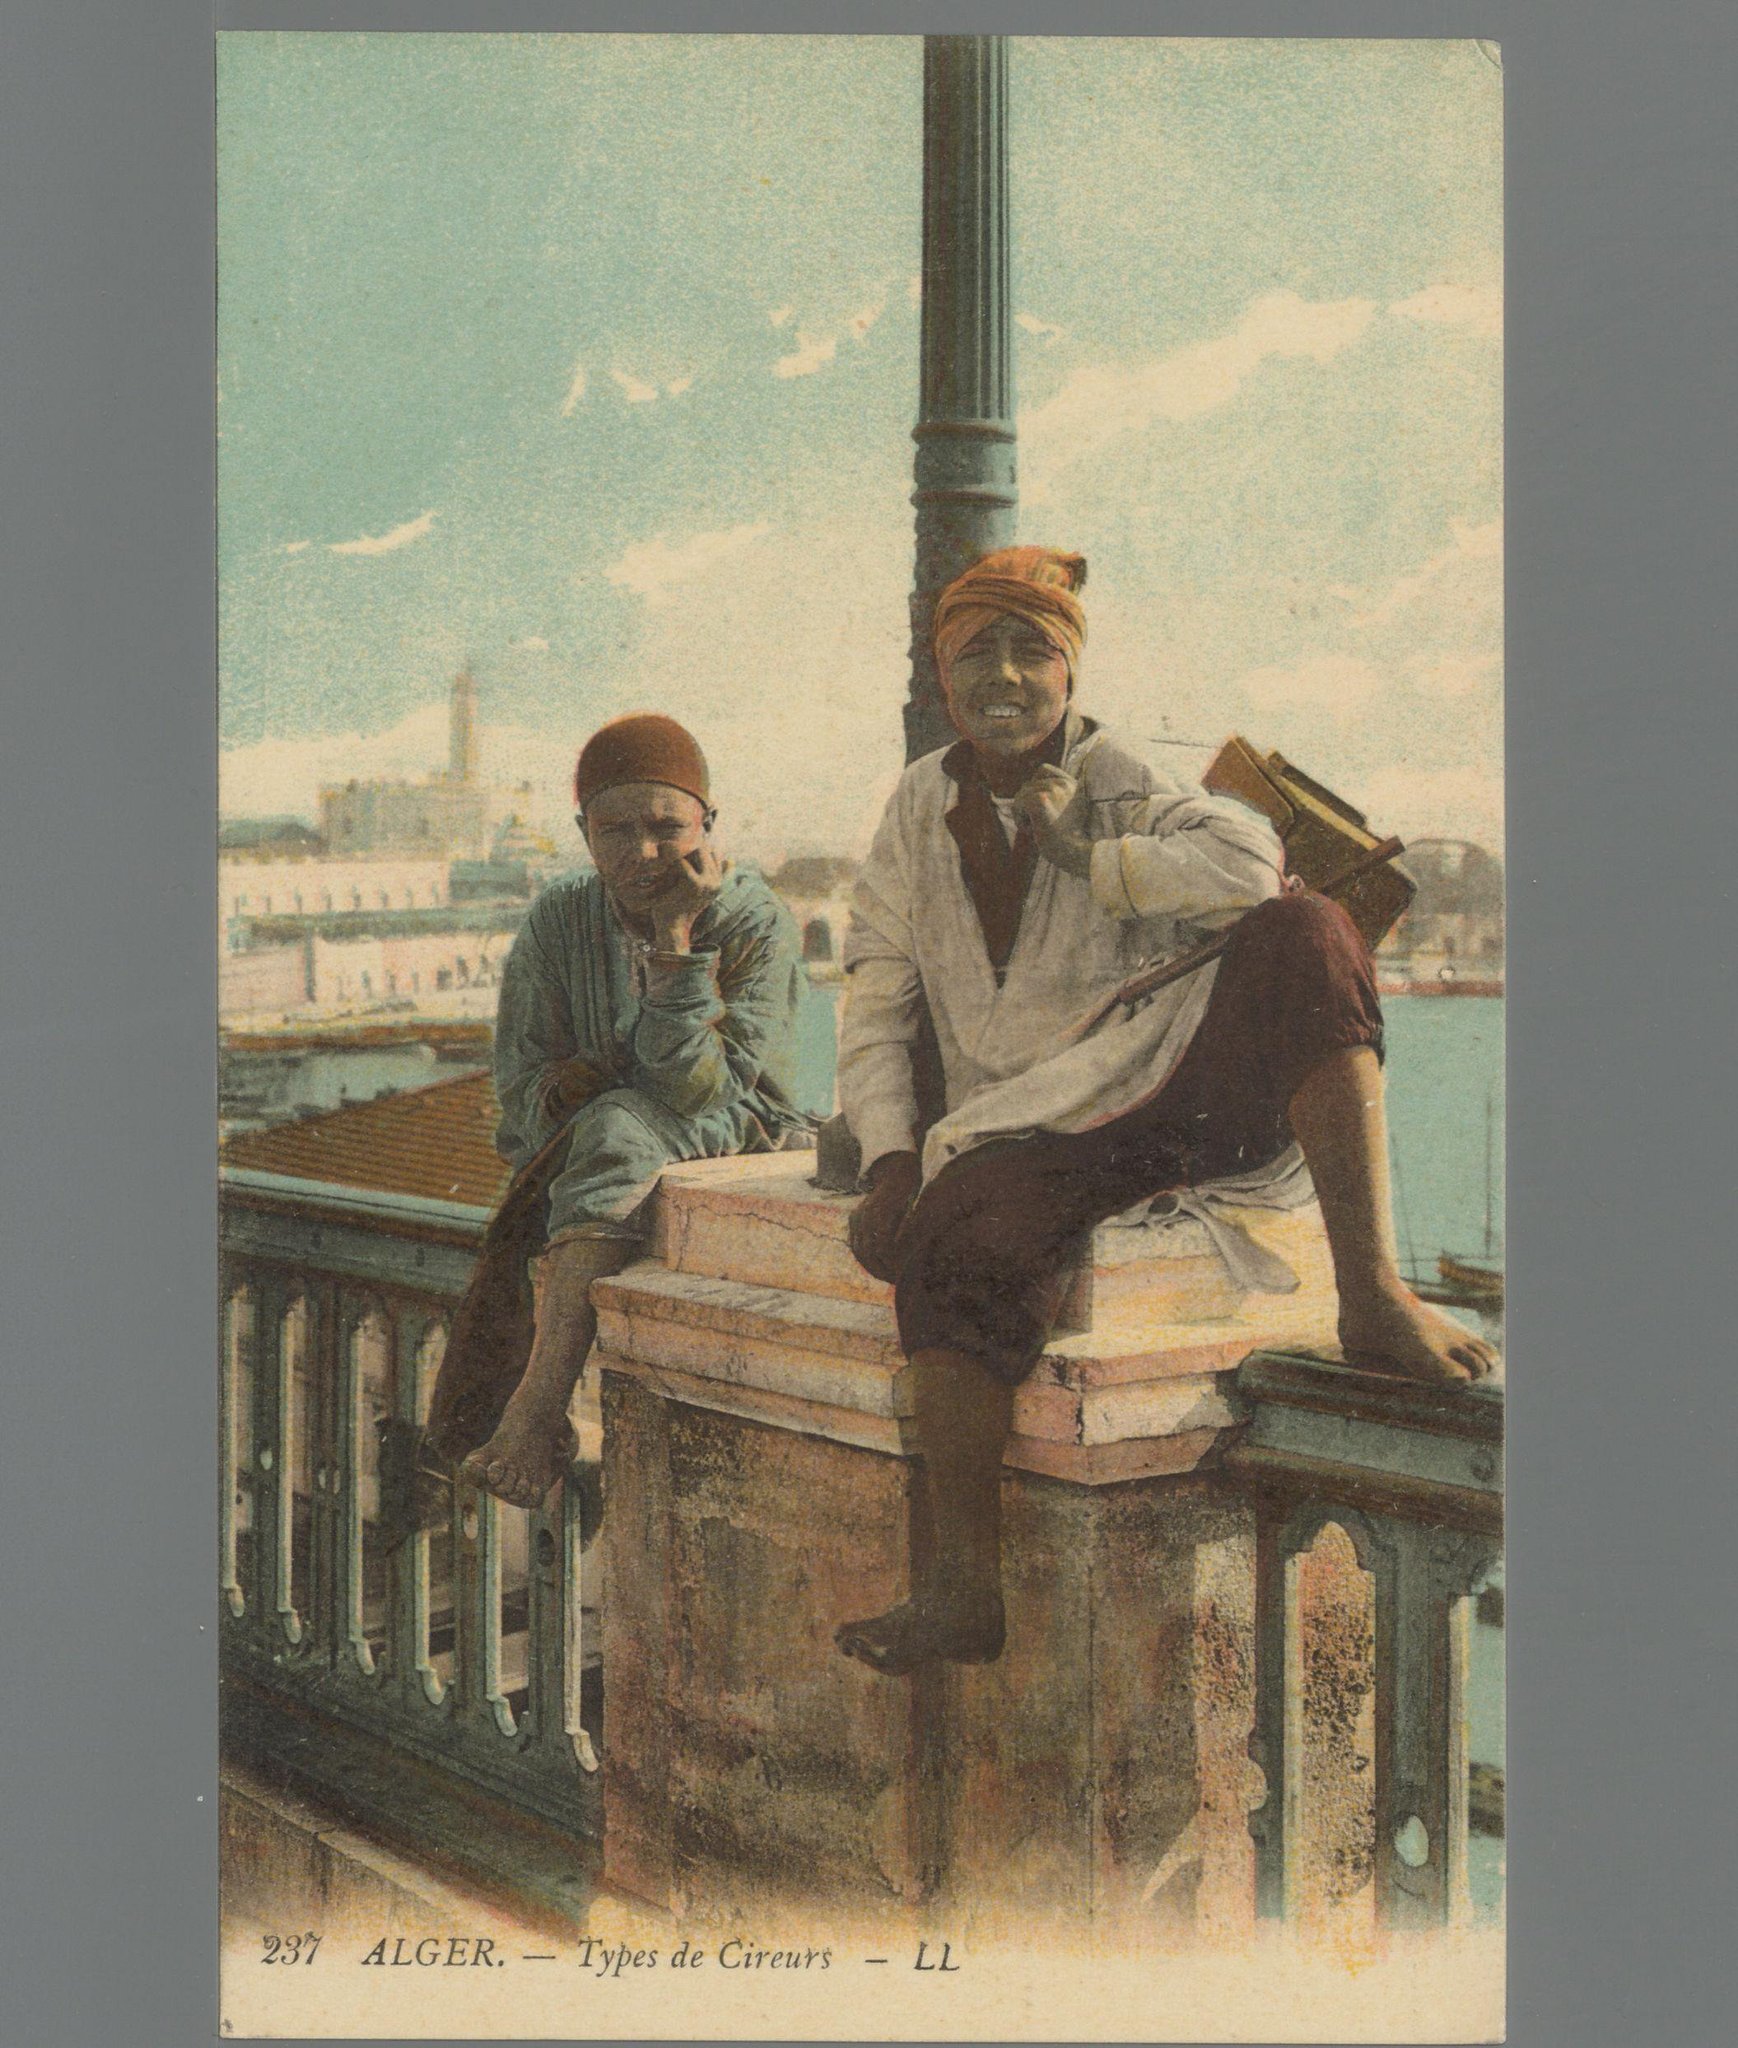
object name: photomechanical print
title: Alger. Types de Cireurs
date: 1903-1920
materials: cardboard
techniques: photograph, lithograph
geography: paris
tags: street-trader, city-view, and landscape with man-made constructions (+ city(-scape) with figures, staffage)